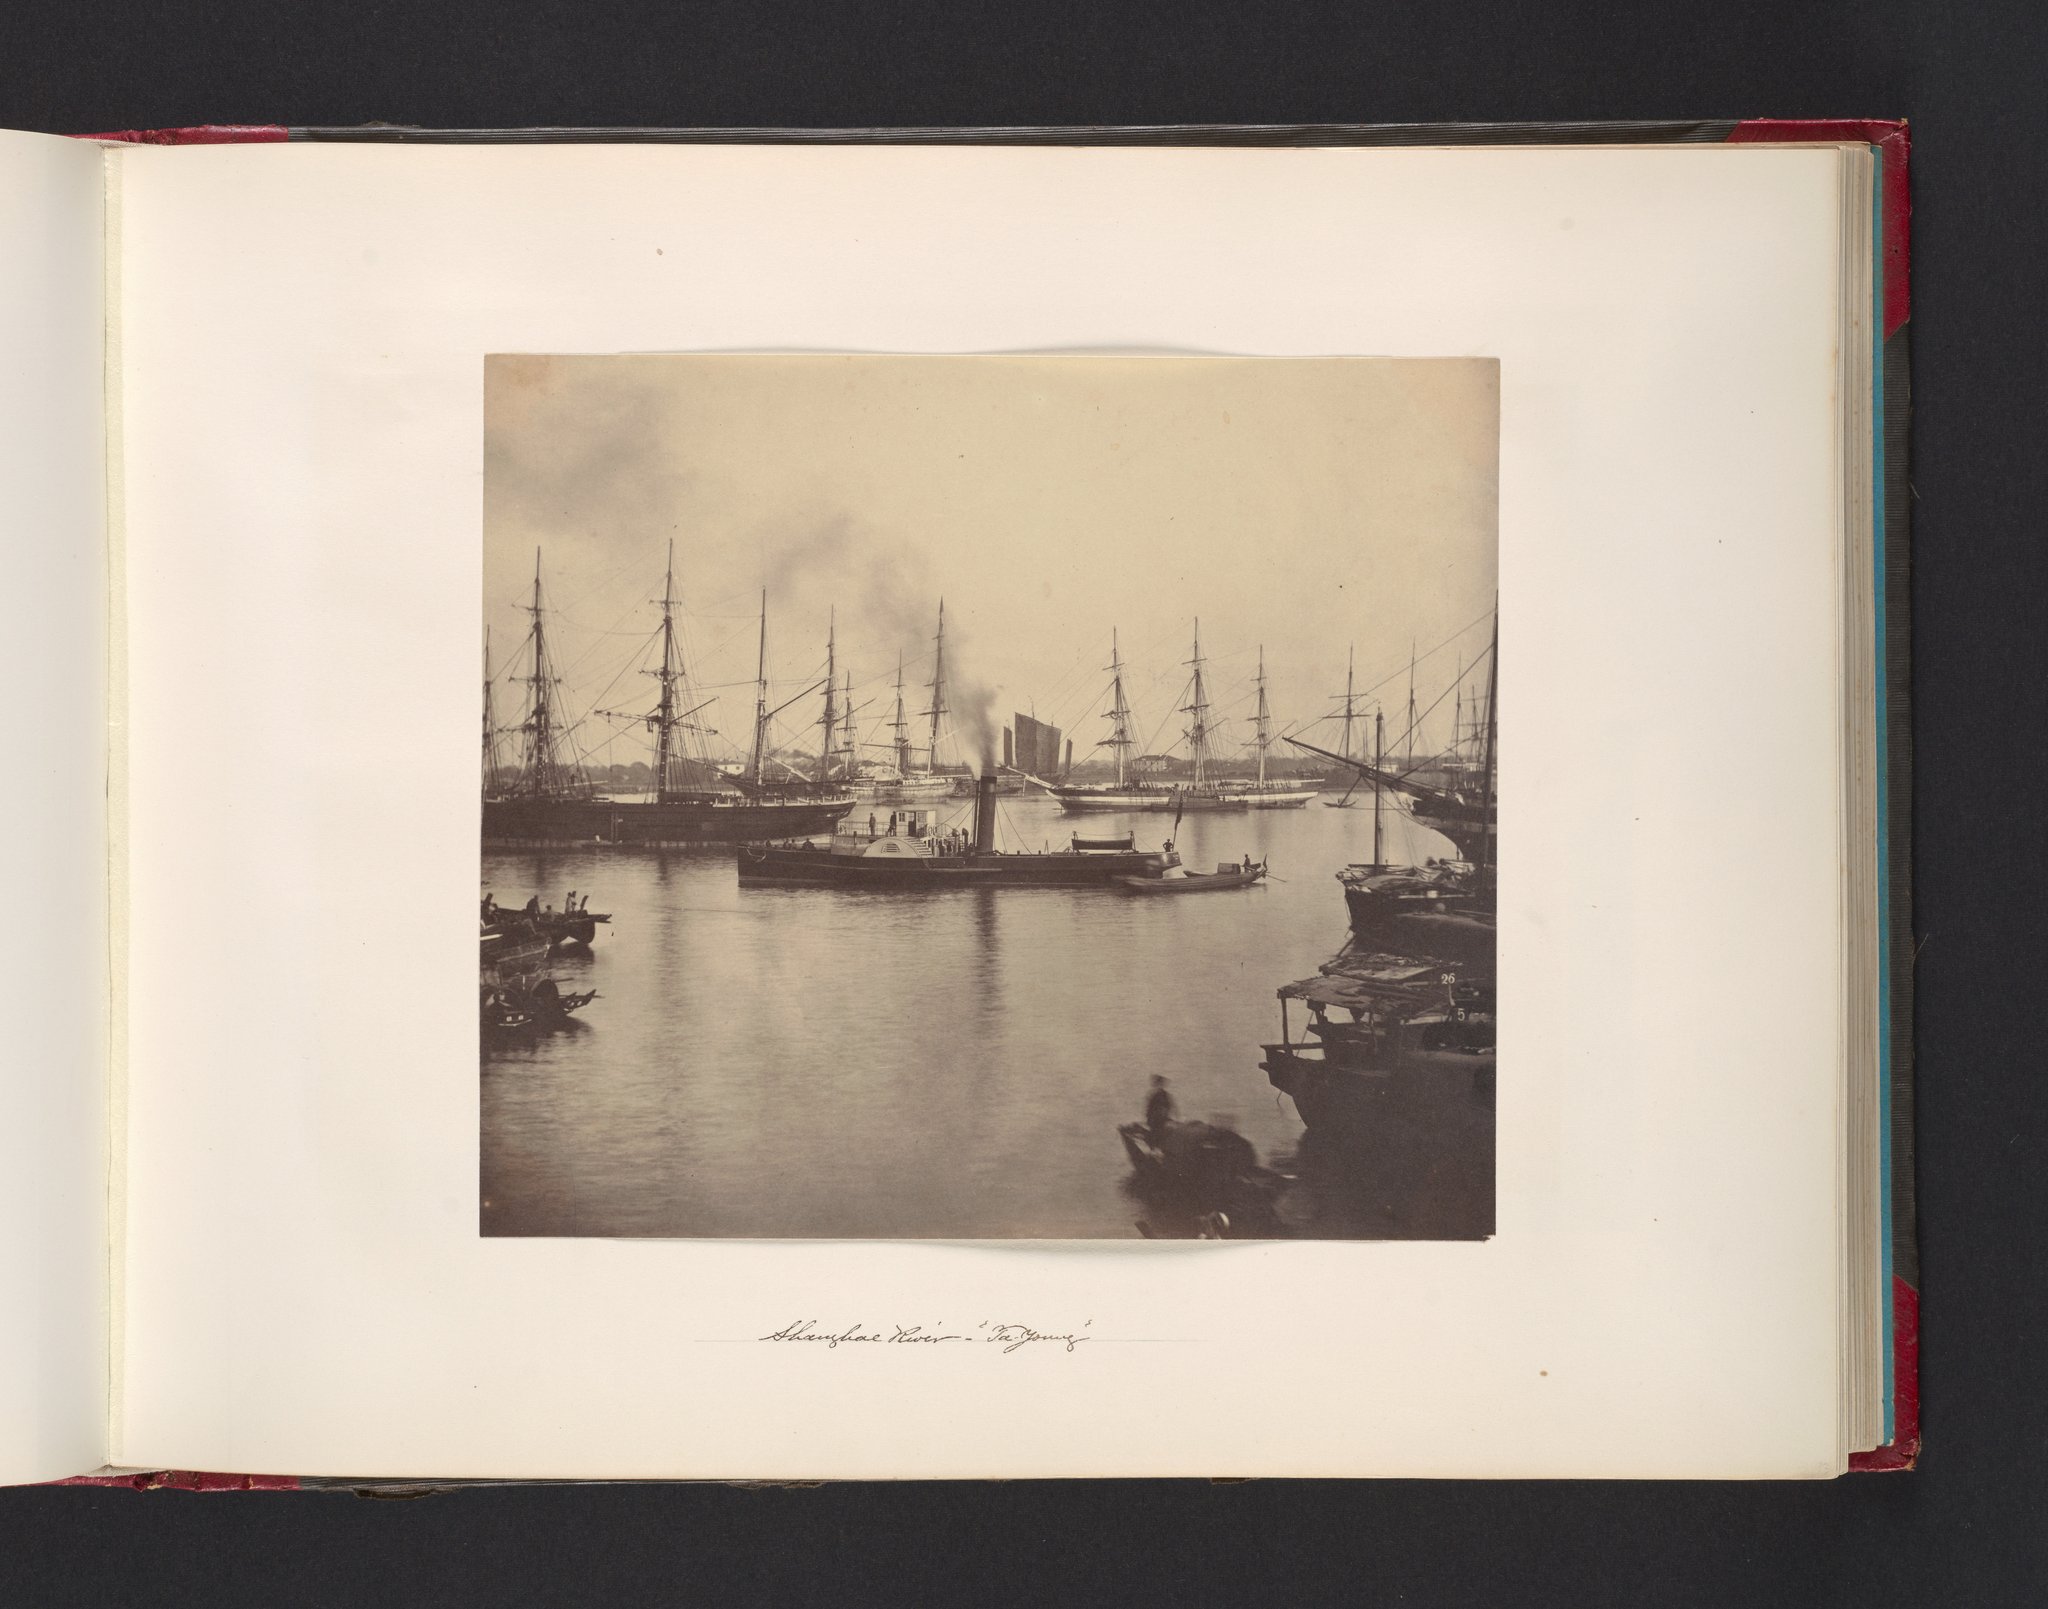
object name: photograph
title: Shanghai River "Ta-Young"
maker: john thomson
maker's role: artist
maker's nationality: british, scottish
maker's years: 1837-1921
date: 1865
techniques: albumen silver print, glass negative